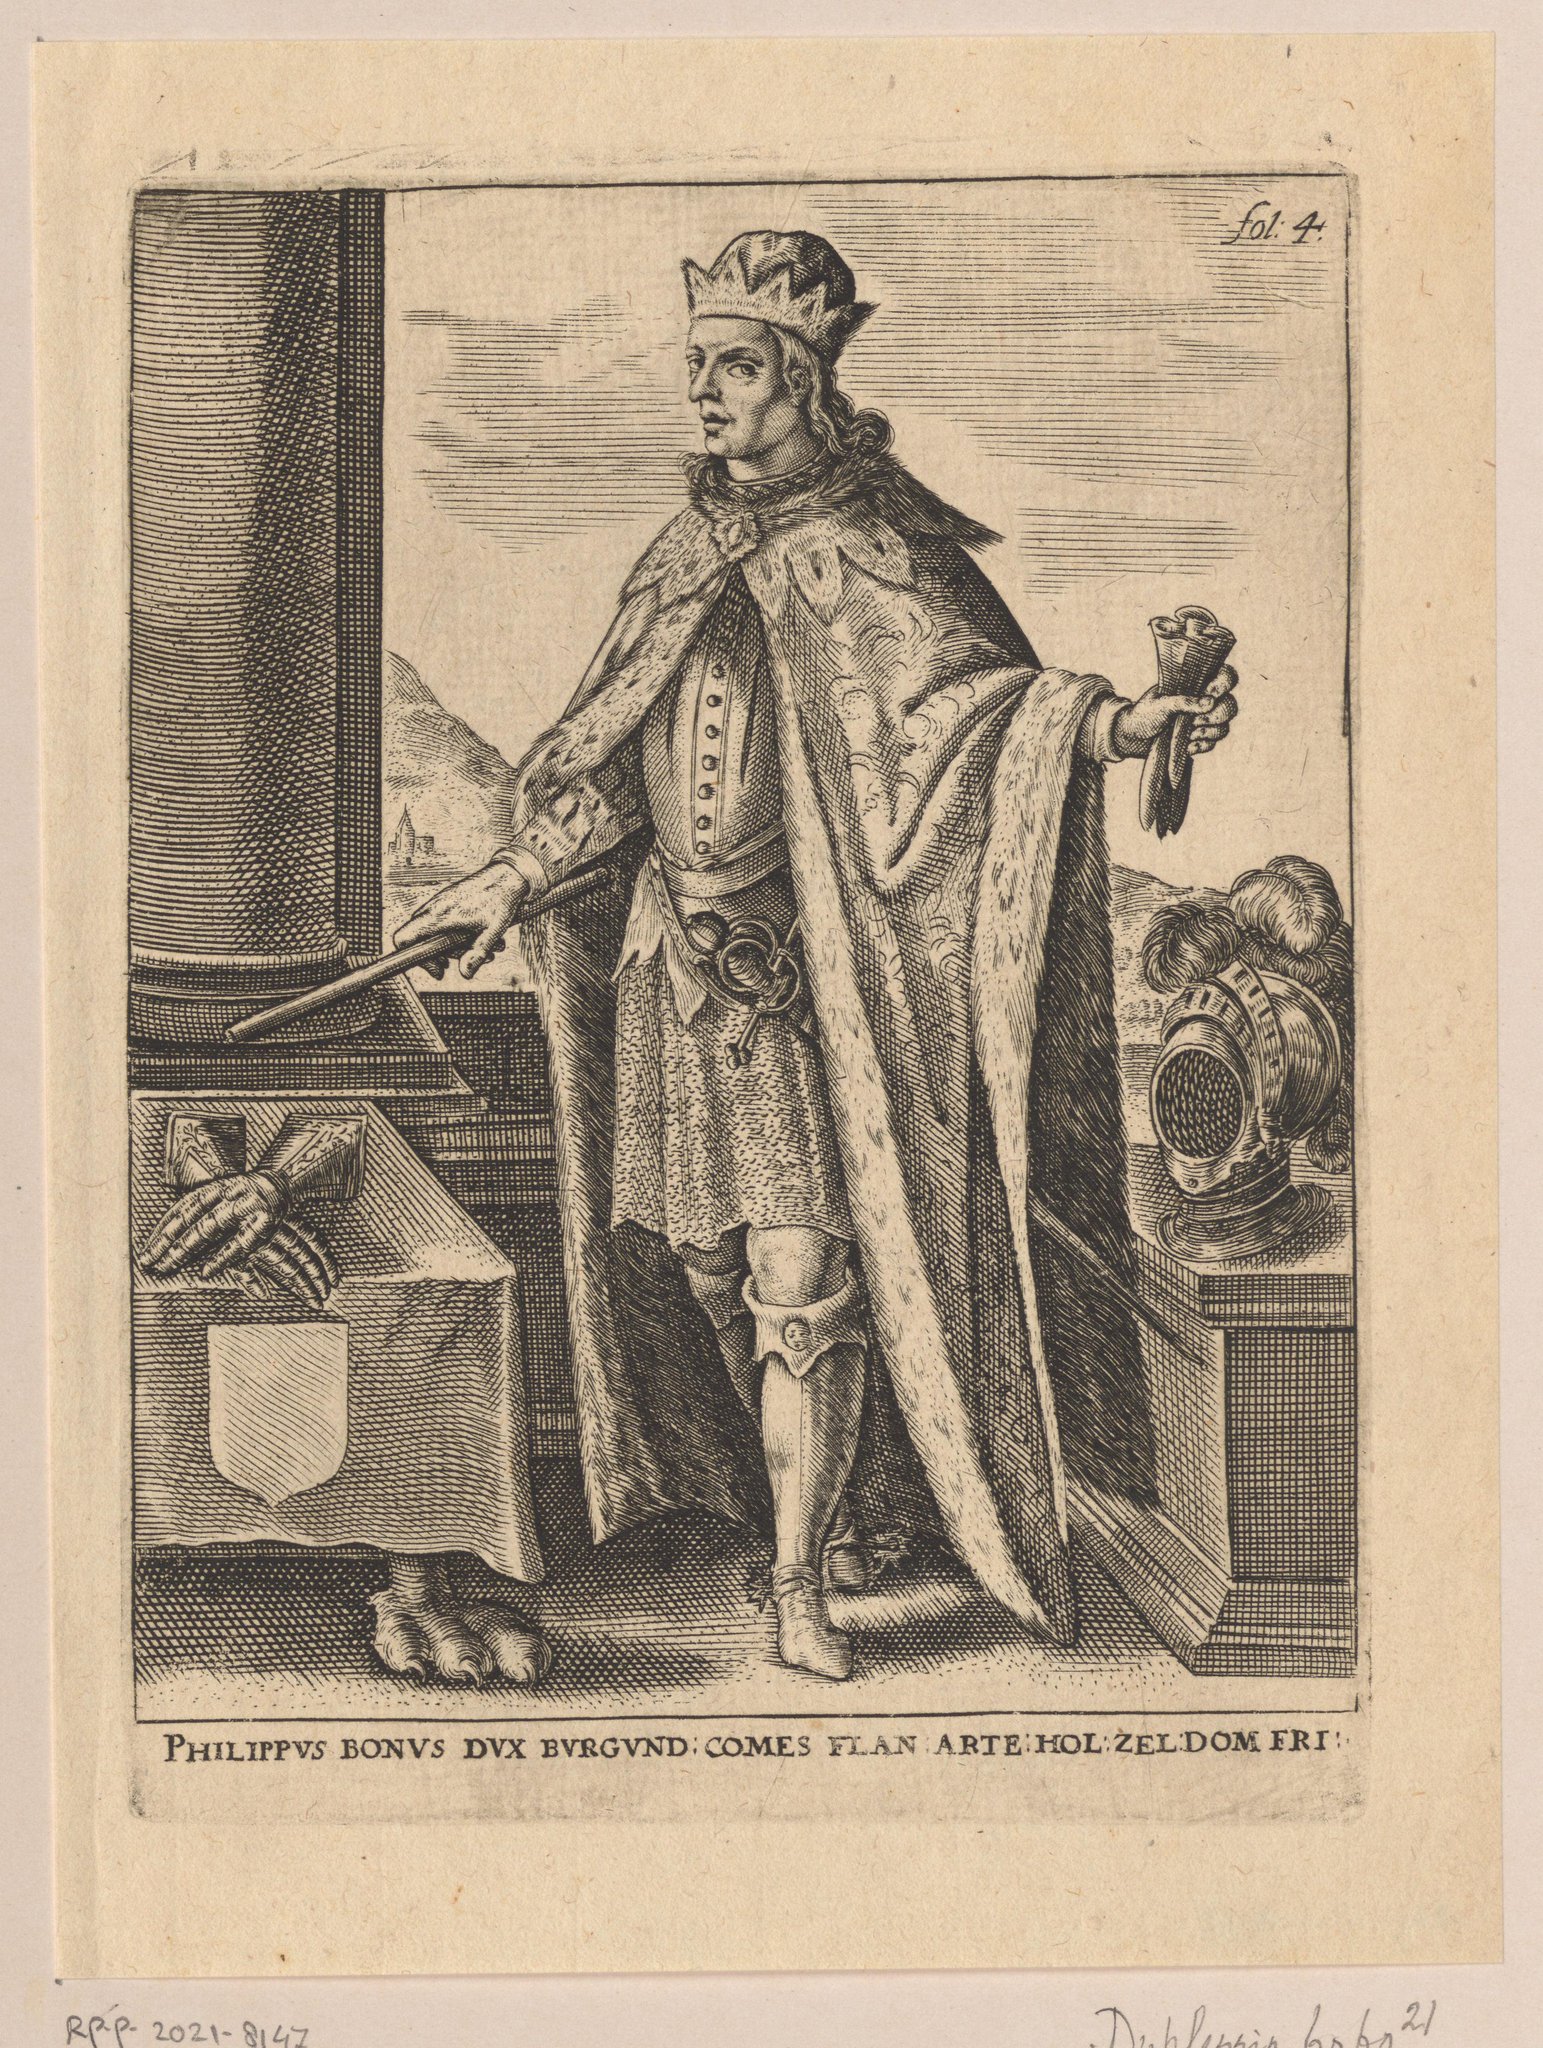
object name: print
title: Portret van Filips de Goede, hertog van Bourgondië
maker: simon van de passe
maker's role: print maker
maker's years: 1595-1647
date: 1605-1647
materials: paper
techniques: engraving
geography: northern netherlands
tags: philip iii the good, historical persons, insignia and symbols of sovereignty (crown, diadem, sceptre, orb, seal, standard, cloak, pectoral)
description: Prent mogelijk uit: Emanuel van Meteren, Historien der Nederlanden, en haar naburen oorlogen tot het jaar 1612 : met heerelijker konterfeijtsels dan ooyt voor dezen verciert en verbetert. Amsterdam: Jan Jacobsz Schipper, 1663.